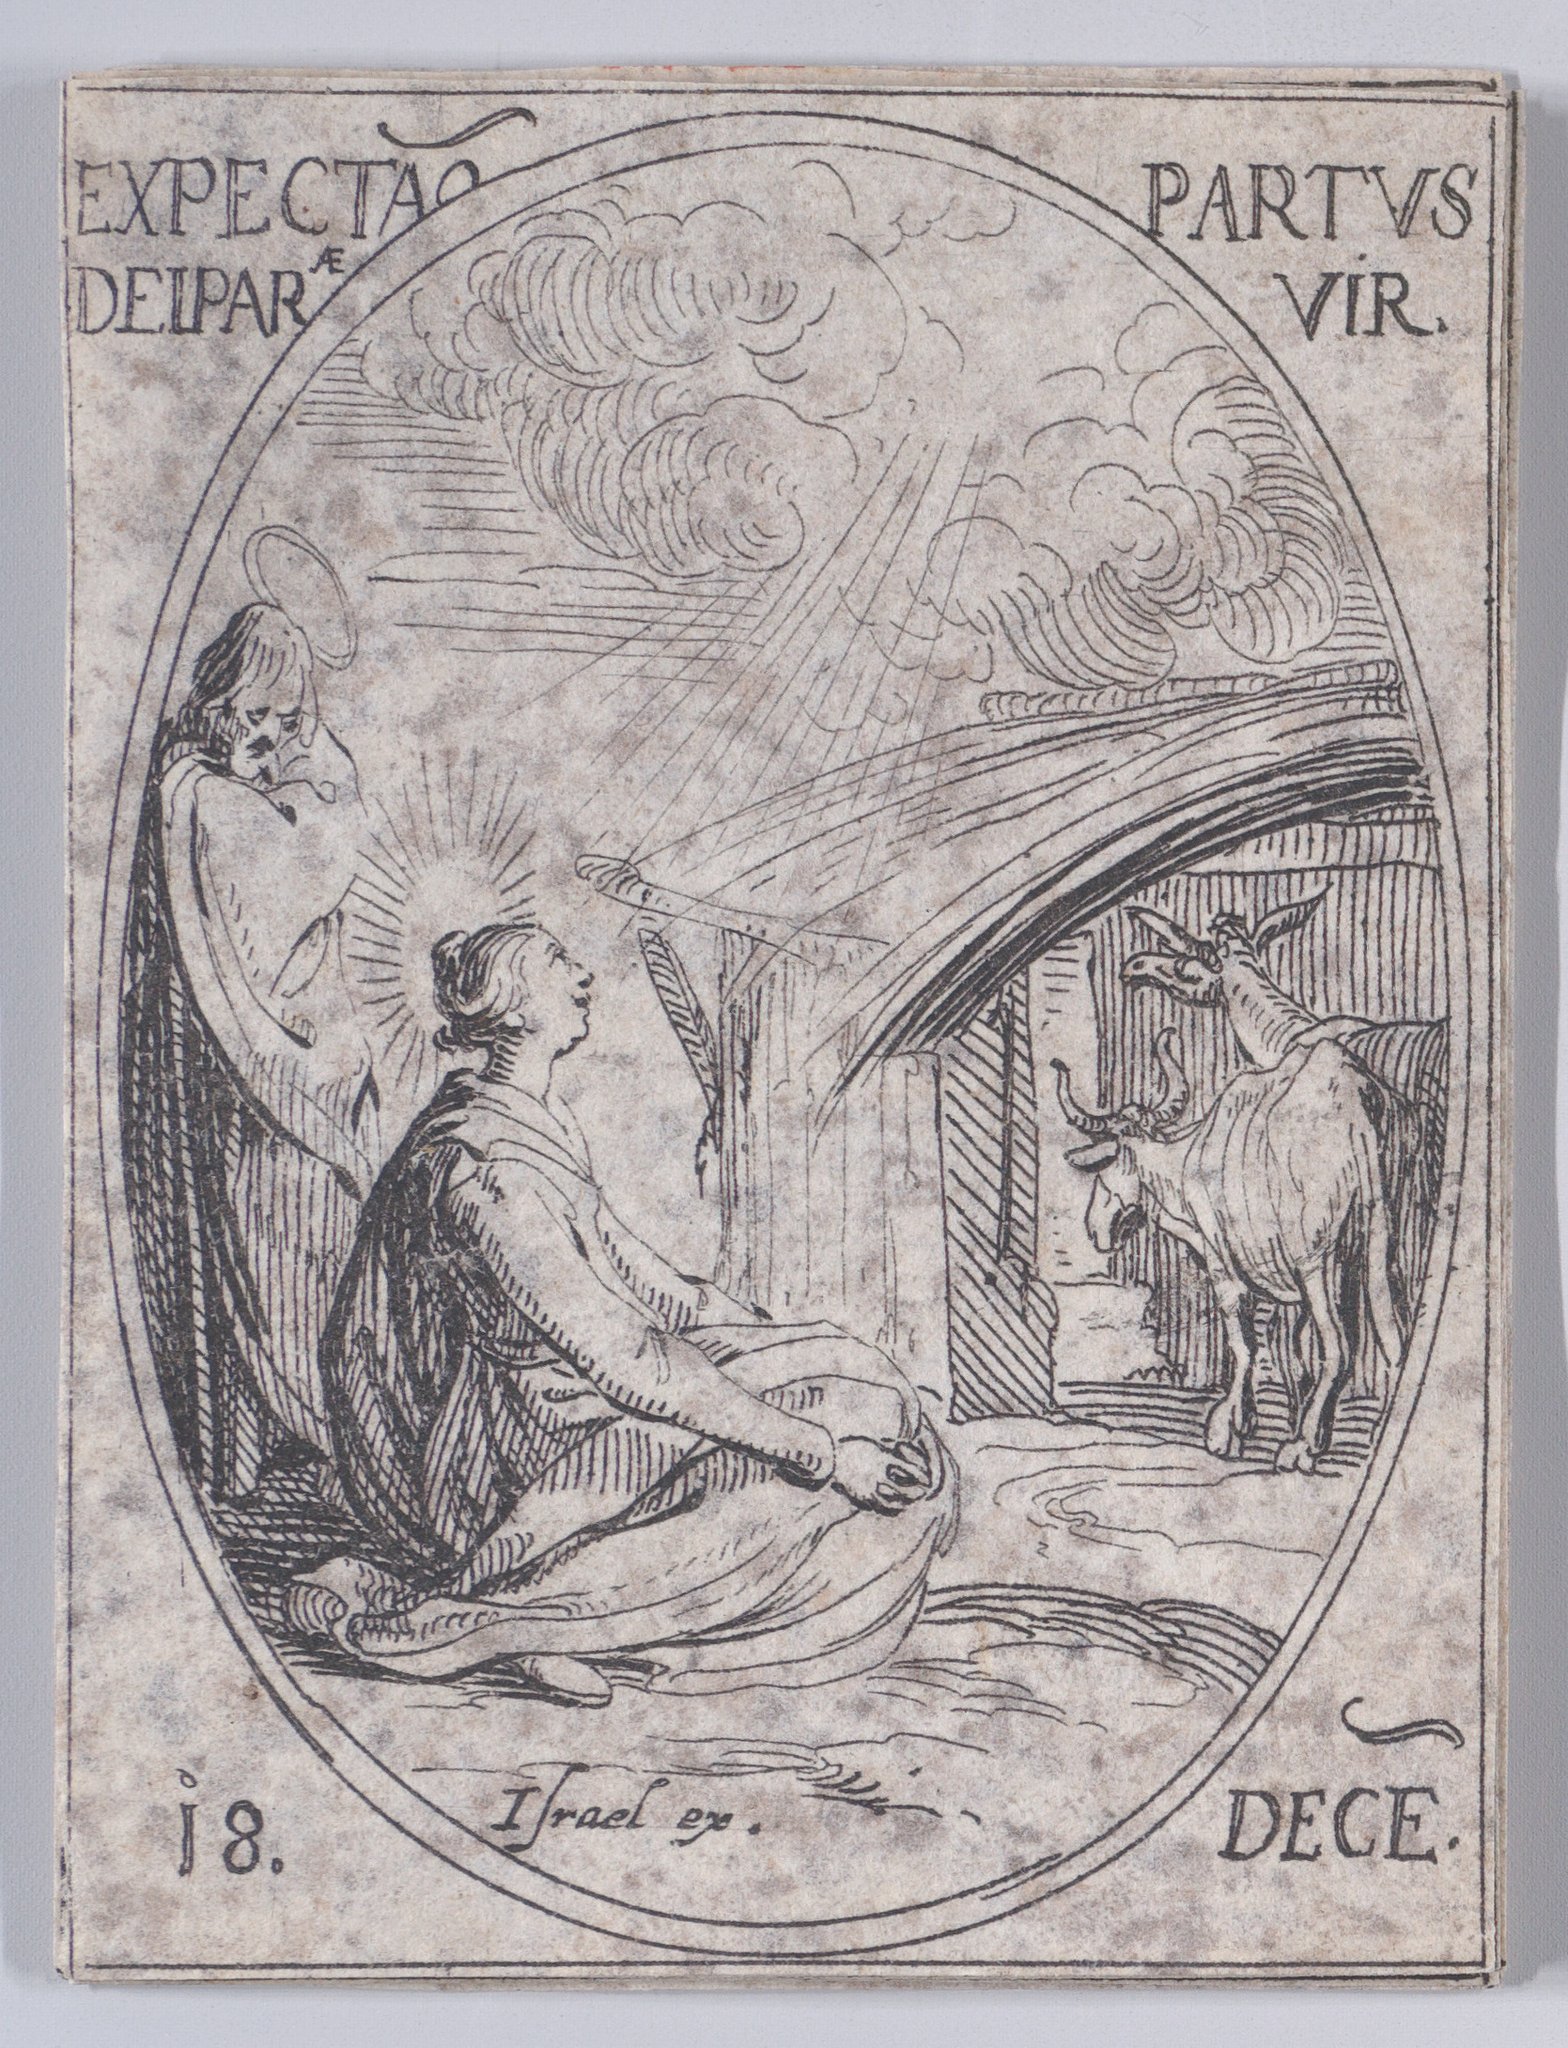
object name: print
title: L'Attente de l'Enfantement de la Vierge (Expectation of the Virgin Mary), December 18th, from "Les Images De Tous Les Saincts et Saintes de L'Année" (Images of All of the Saints and Religious Events of the Year)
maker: jacques callot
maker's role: artist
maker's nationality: french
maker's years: 1592-1635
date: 1636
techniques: etching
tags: animals,virgin mary